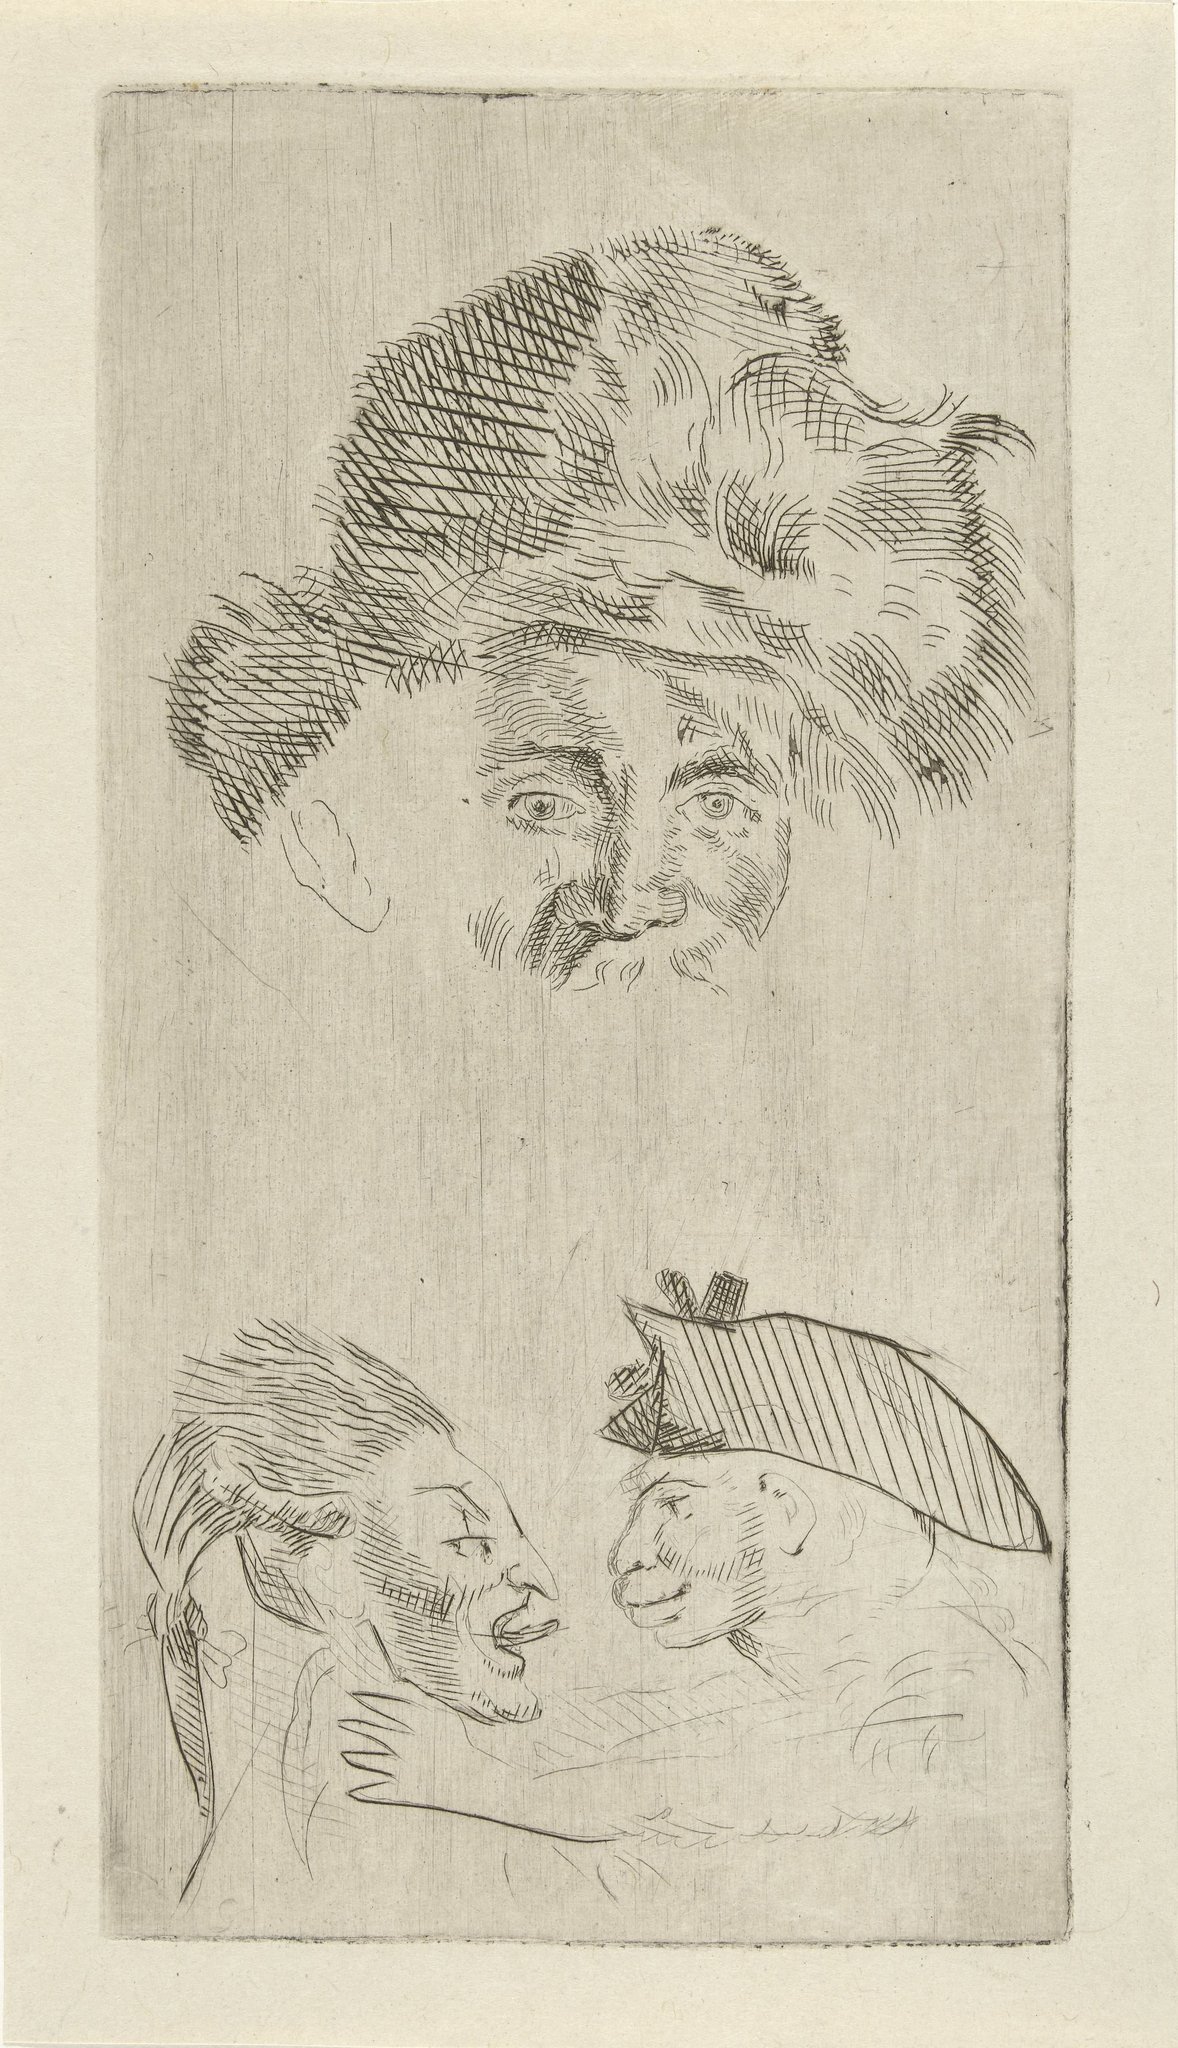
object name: print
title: Studieblad met drie koppen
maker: jac. franc. gaal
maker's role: print maker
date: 1750-1799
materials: paper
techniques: etching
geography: netherlands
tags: historical persons not known by name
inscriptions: collector's mark: Lugt 240